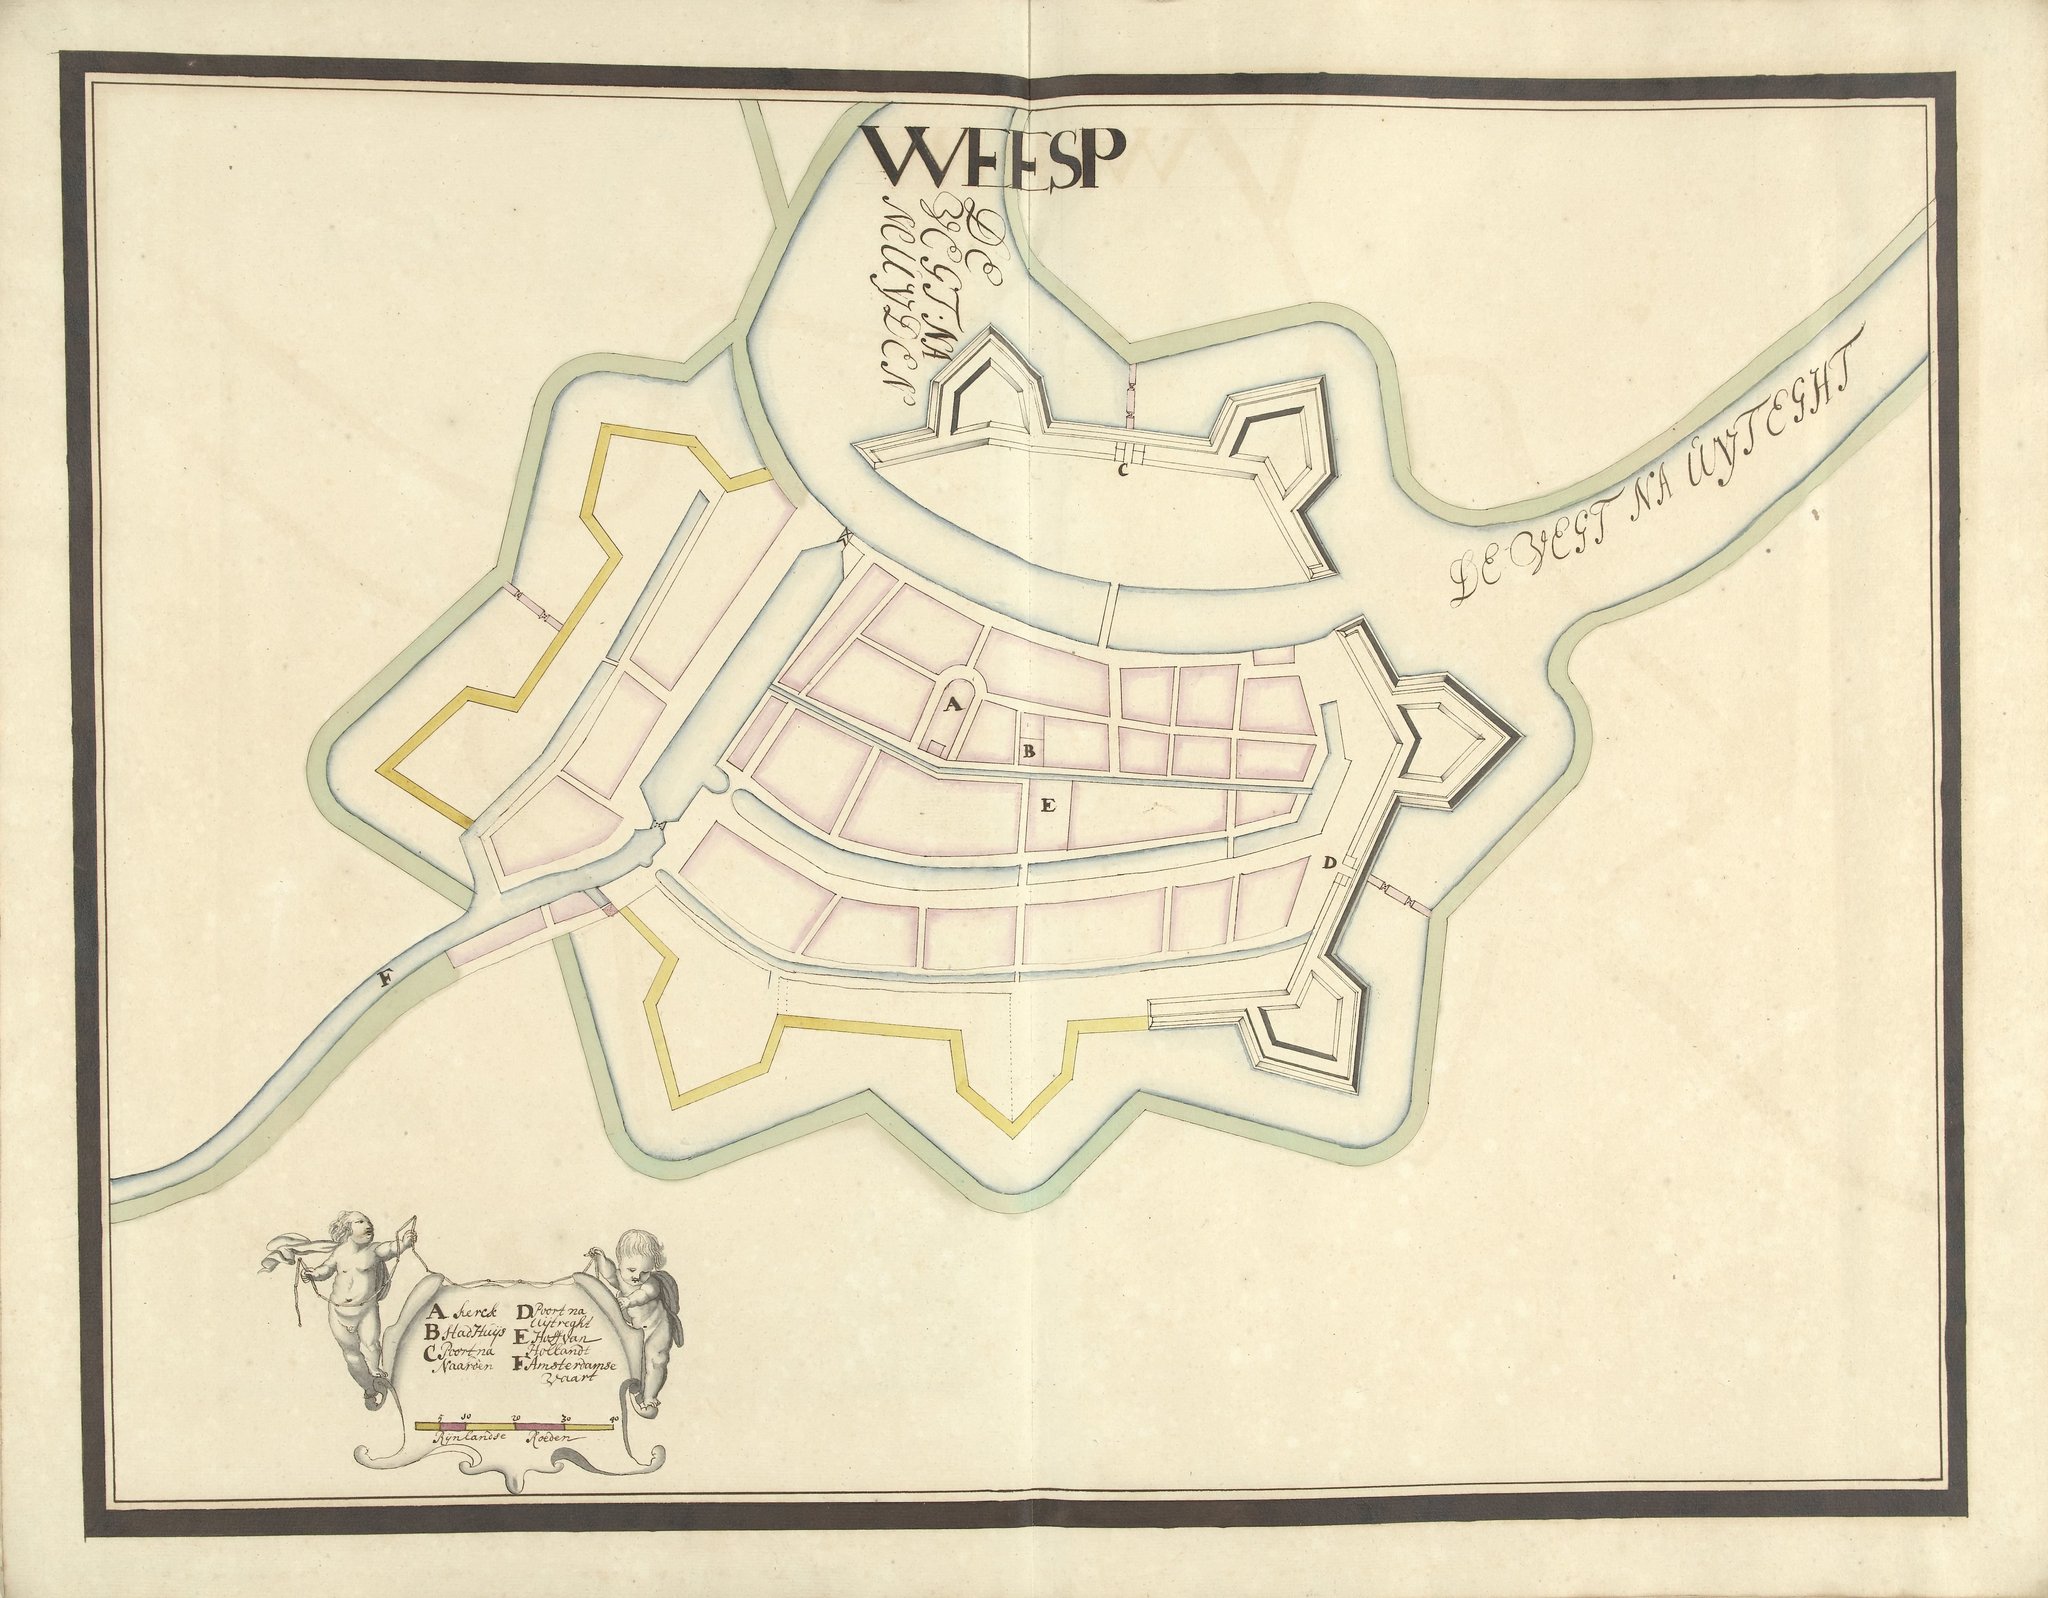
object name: drawing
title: Weesp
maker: samuel du ry de champdoré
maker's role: draughtsman, engineer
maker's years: 1651-1729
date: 1701-1715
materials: paper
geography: netherlands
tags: fortress, maps of cities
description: Plattegrond van de versterkingen om de stad Weesp, ca. 1701-1715. Linksonder een cartouche met de legenda A-F in het Nederlands, met twee putti met een meetlint. Onderdeel van een verzameling getekende plannen van versterkte plaatsen in Nederland en omringende landen ten tijde van de Spaanse Successieoorlog (deel A).